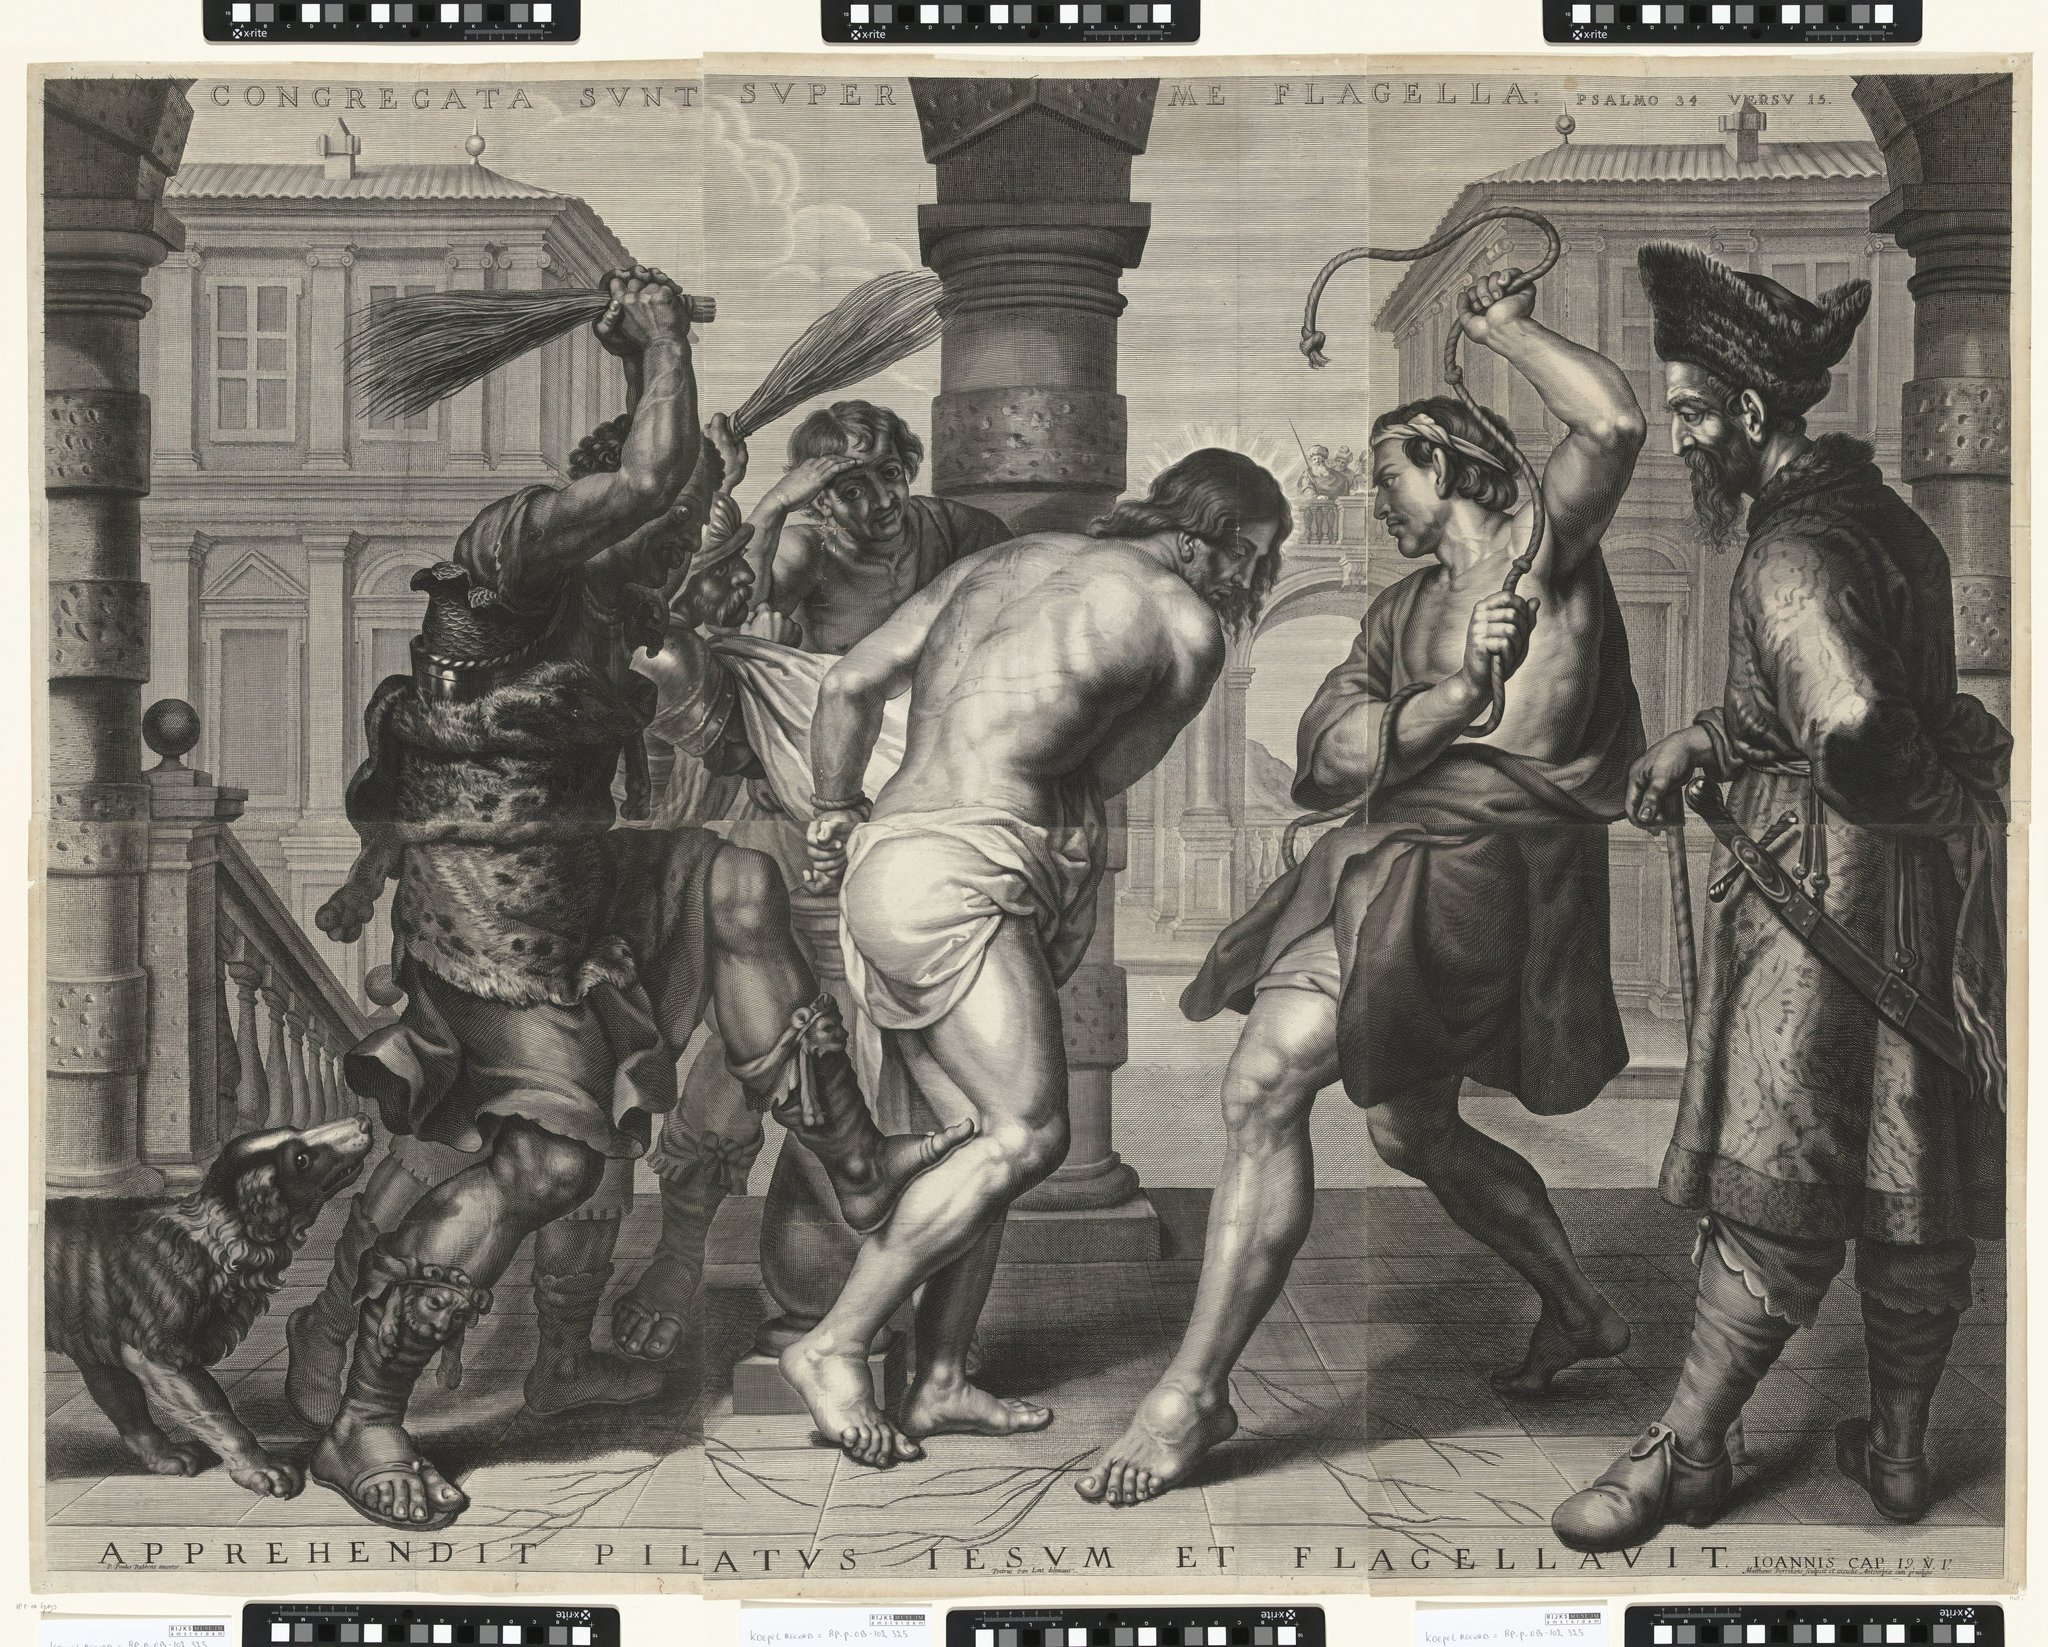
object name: print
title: Geseling van Christus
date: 1625-1670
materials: paper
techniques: engraving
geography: antwerp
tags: flagellation by soldiers, christ usually tied to a column (matthew 27:26; mark 15:15; john 19:1)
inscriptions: collector's mark: Lugt 240 of 1838, number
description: In het midden van de prent staat Christus. Hij wordt door twee mannen gegeseld. Een man heeft een roede vast, de ander een zweep met knopen. Twee andere mannen houden Christus in bedwang. Rechts van de prent kijkt Pilatus toe. Op de achtergrond de Farizeeën en schriftgeleerden, die van op afstand de marteling volgen. De prent heeft een Latijns bovenschrift met een citaat uit Psalm 34 (34:15) en een Latijns onderschrift met een citaat uit het evangelie van Johannes (Johannes 19:5).